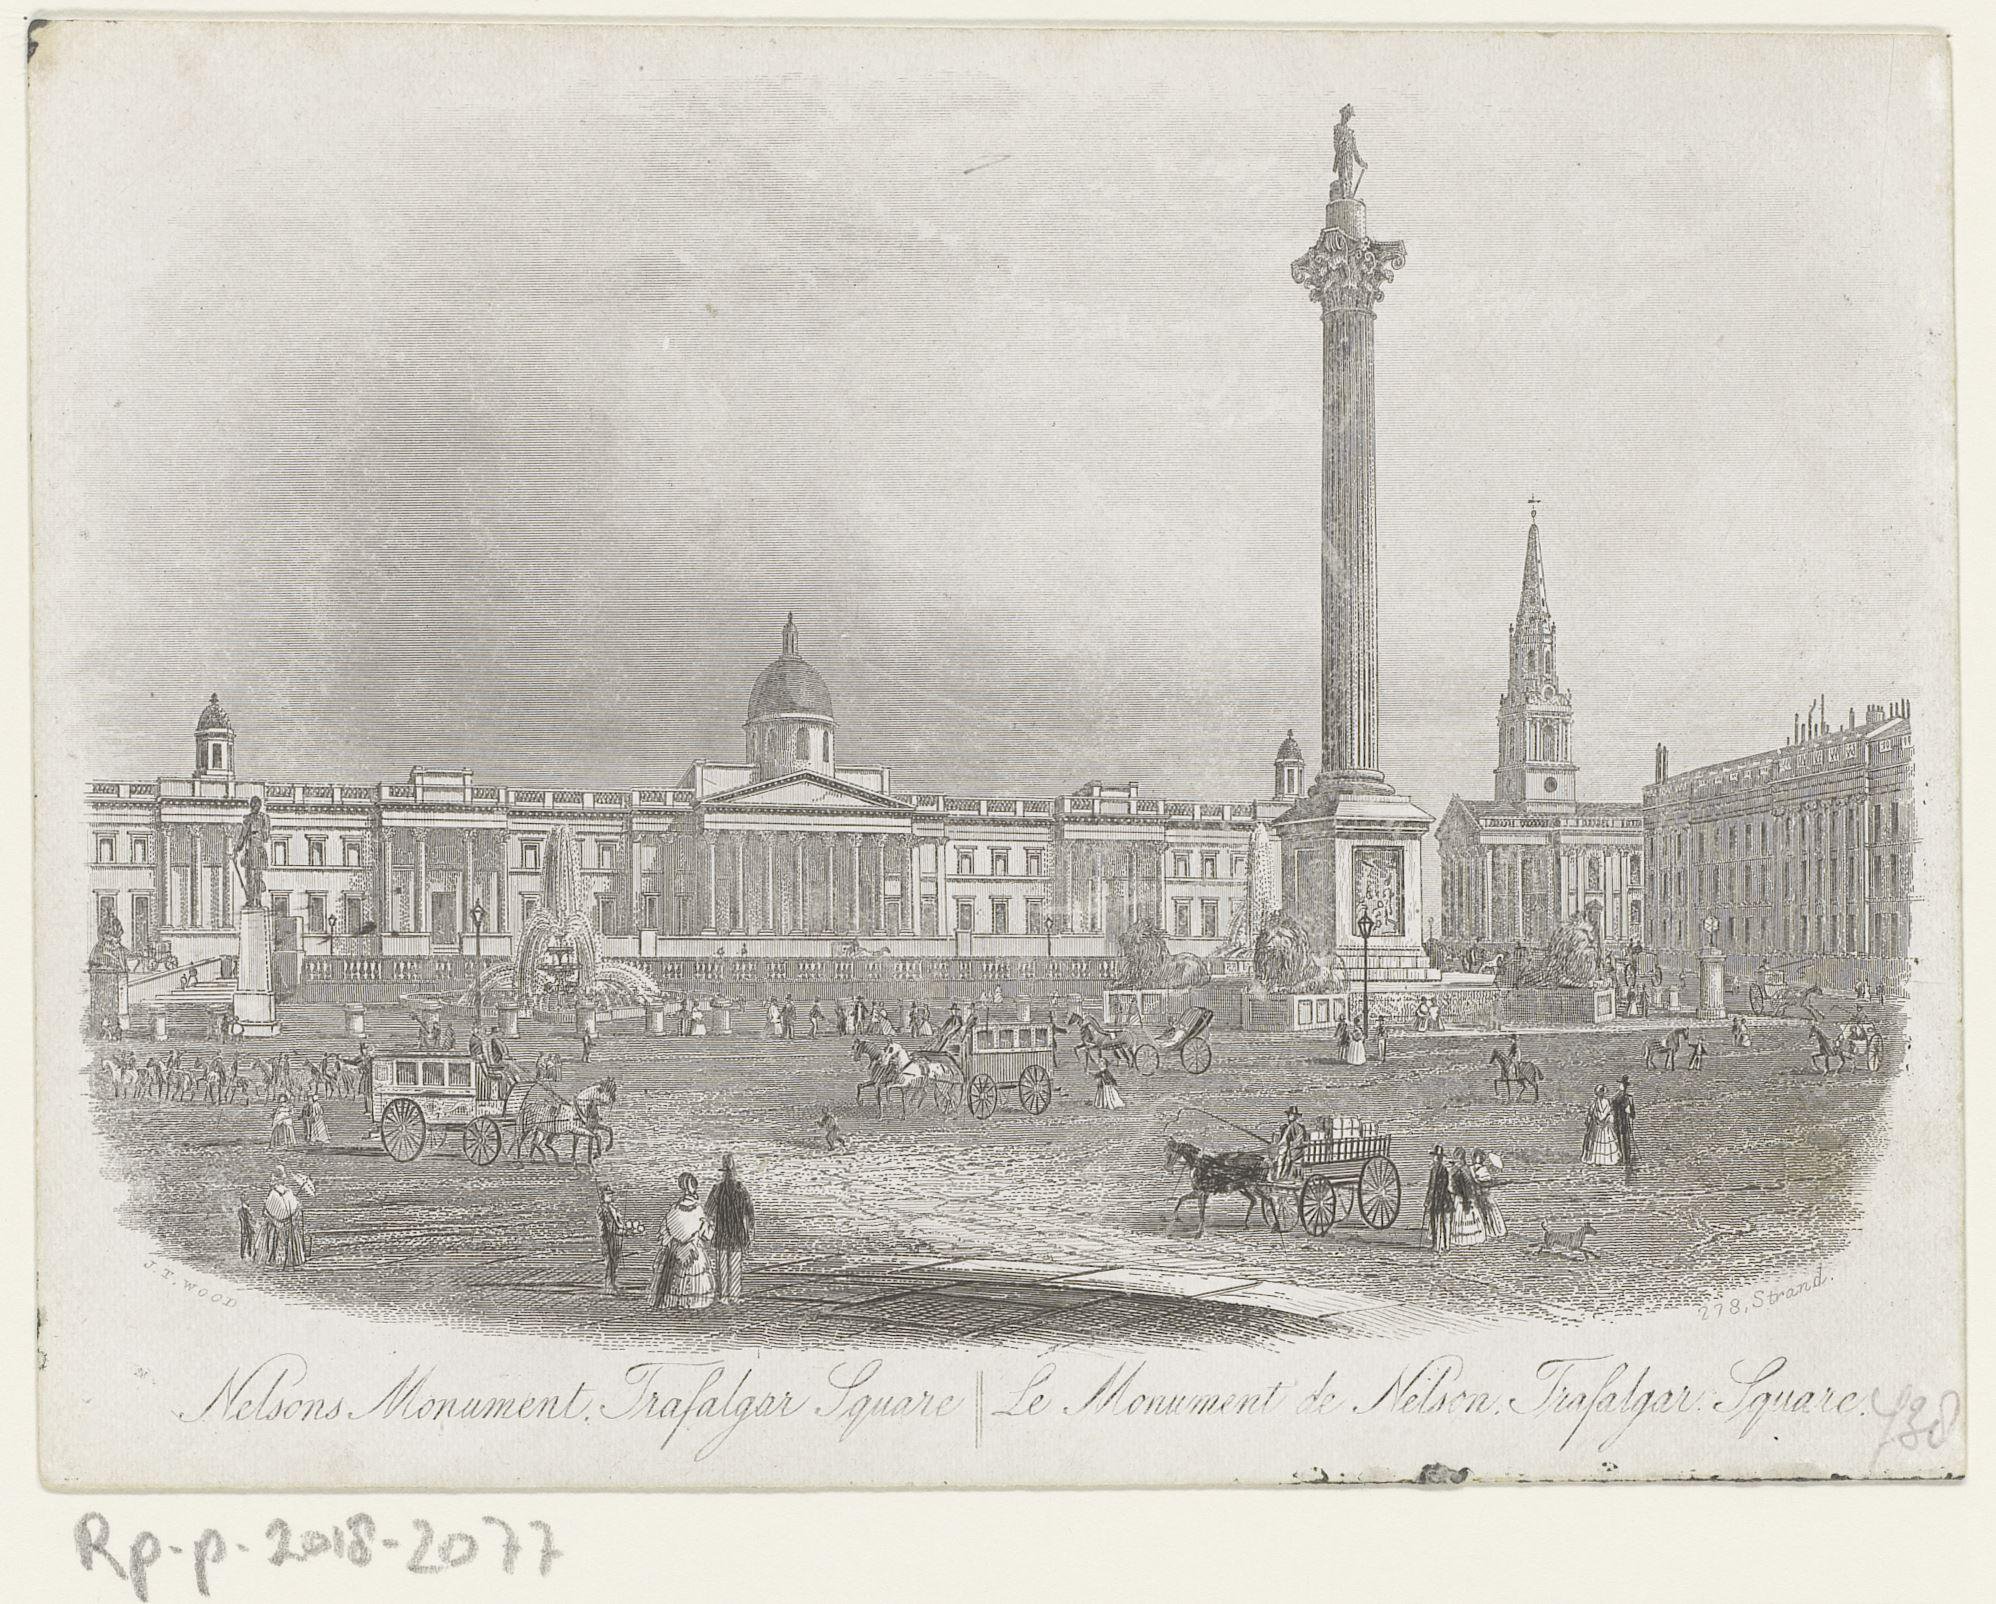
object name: print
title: Gezicht op Nelson's Column, te Londen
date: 1843-1885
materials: paper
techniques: etching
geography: london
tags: column, pillar ~ architecture, monument, statue